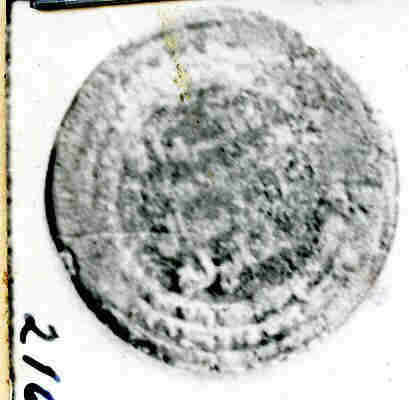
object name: coin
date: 976-979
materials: silver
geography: iran